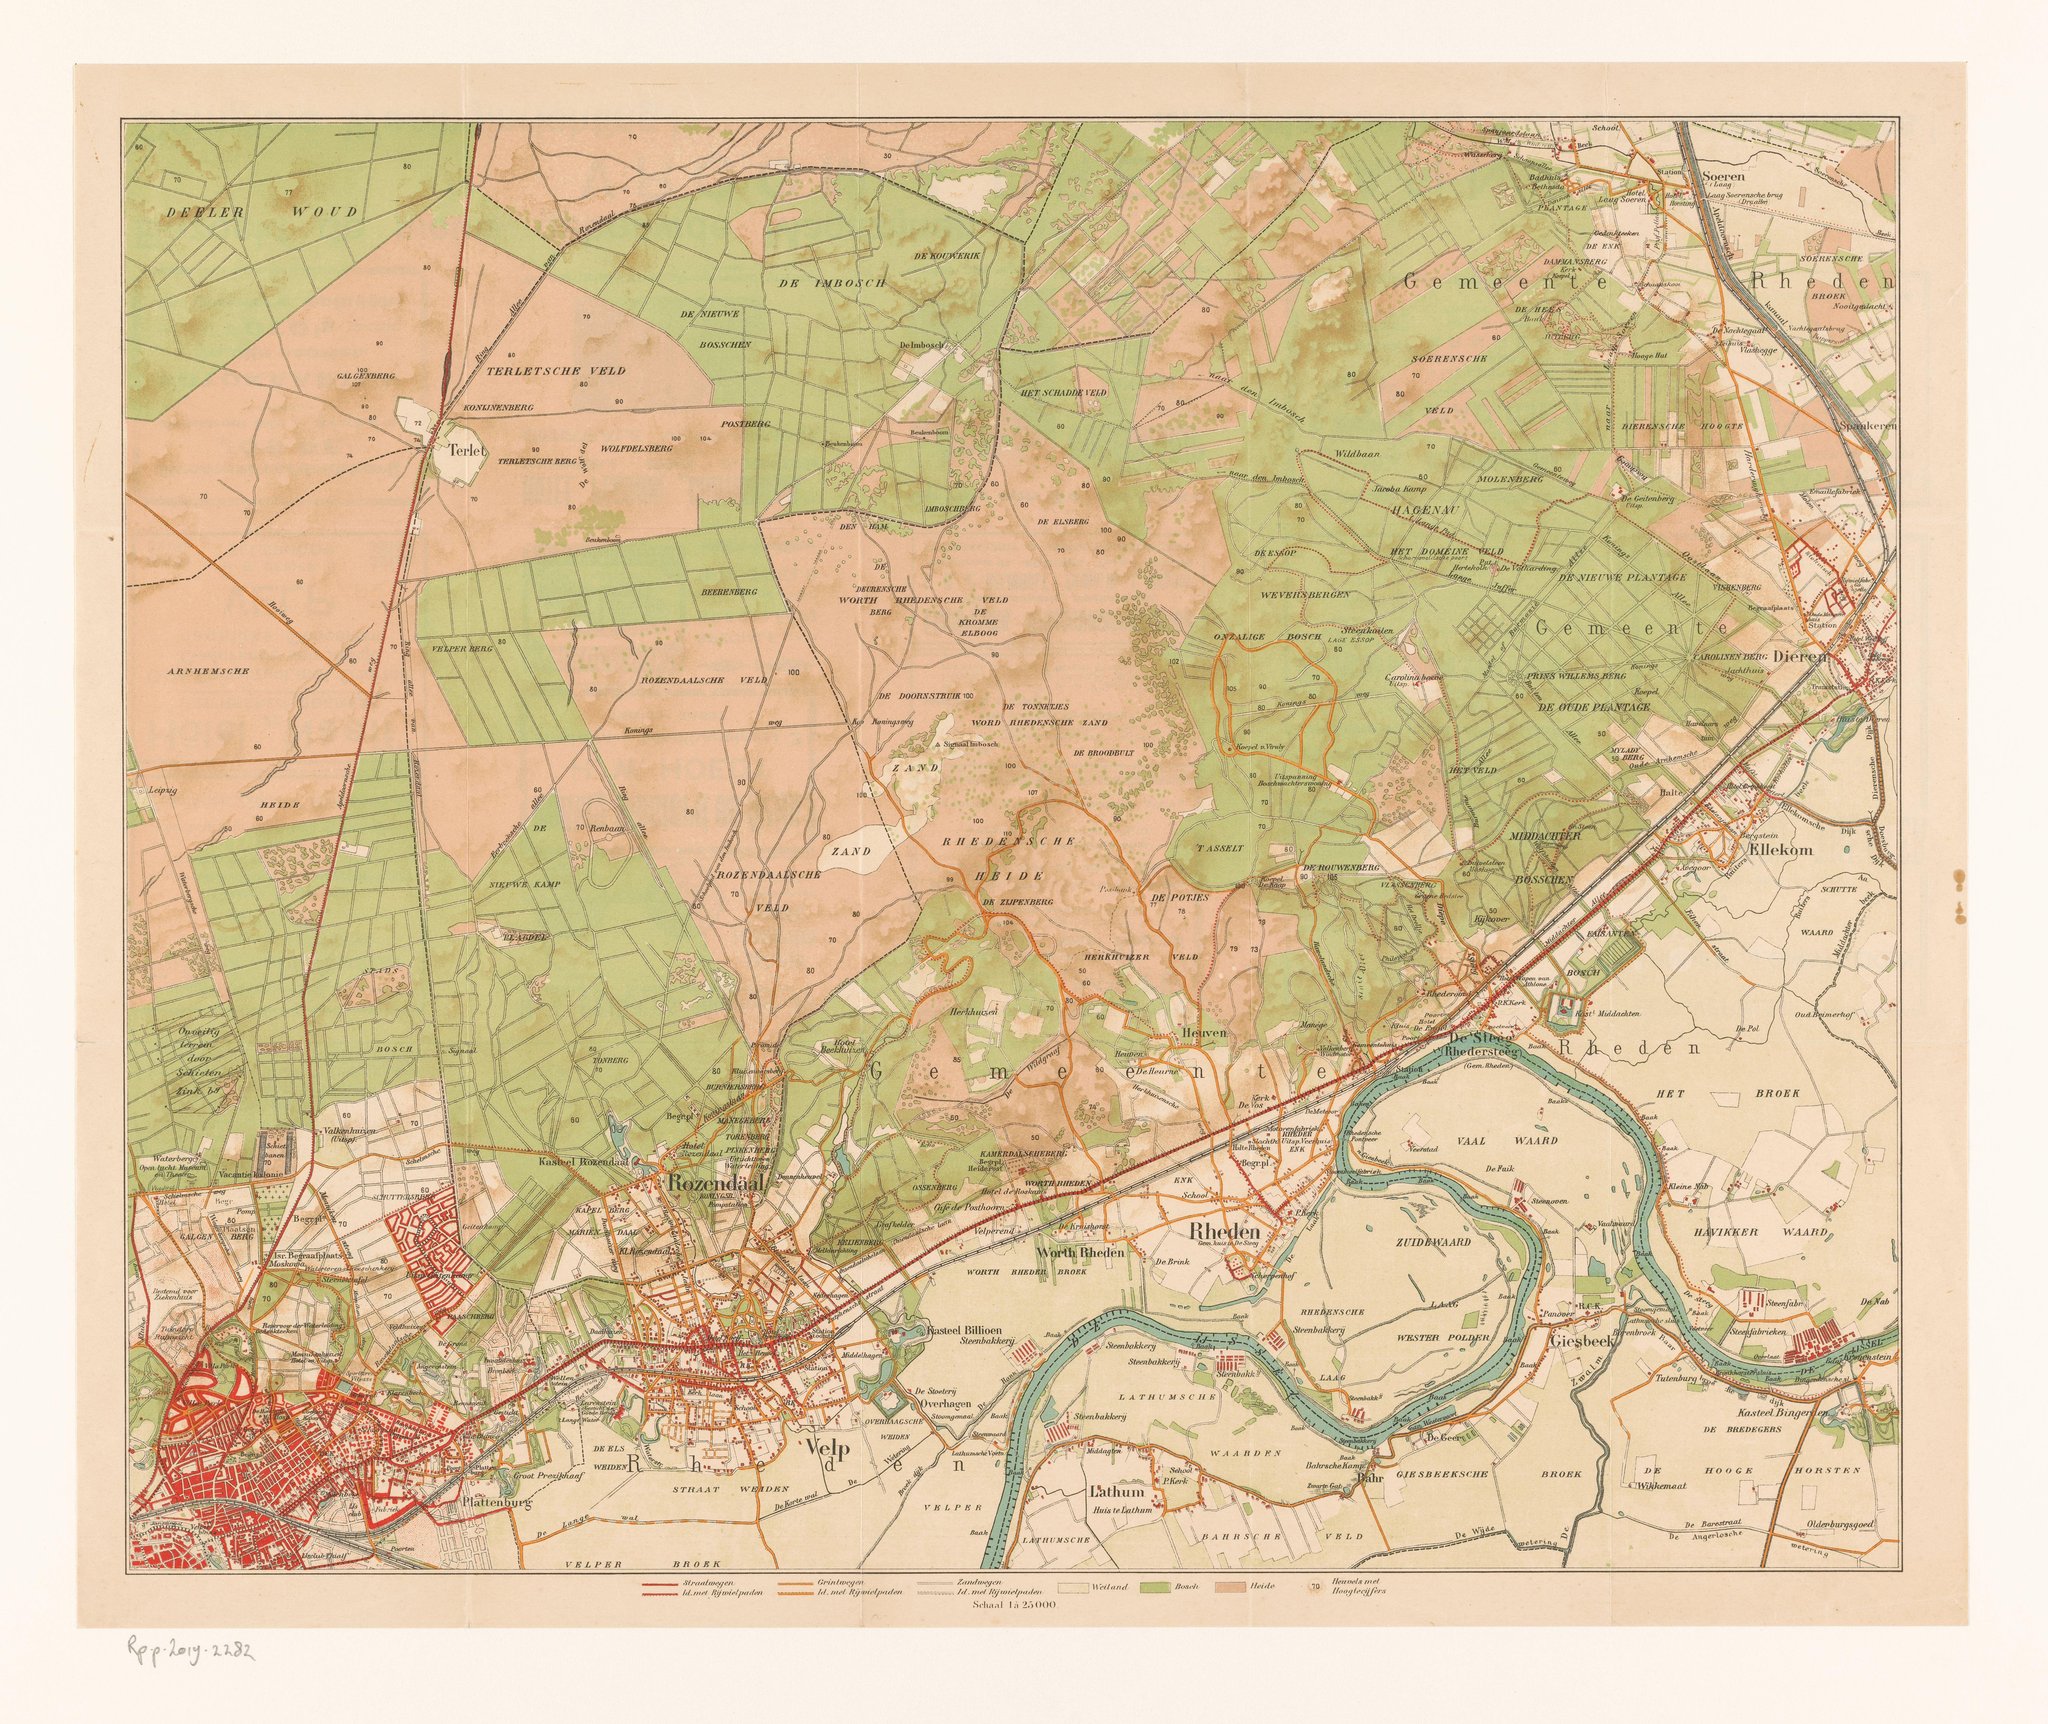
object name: print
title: Kaart van de omgeving van Arnhem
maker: Anonymous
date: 1929-1939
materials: paper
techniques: lithograph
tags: maps of separate countries or regions, gelderland, arnhem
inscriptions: collector's mark: Lugt 2228